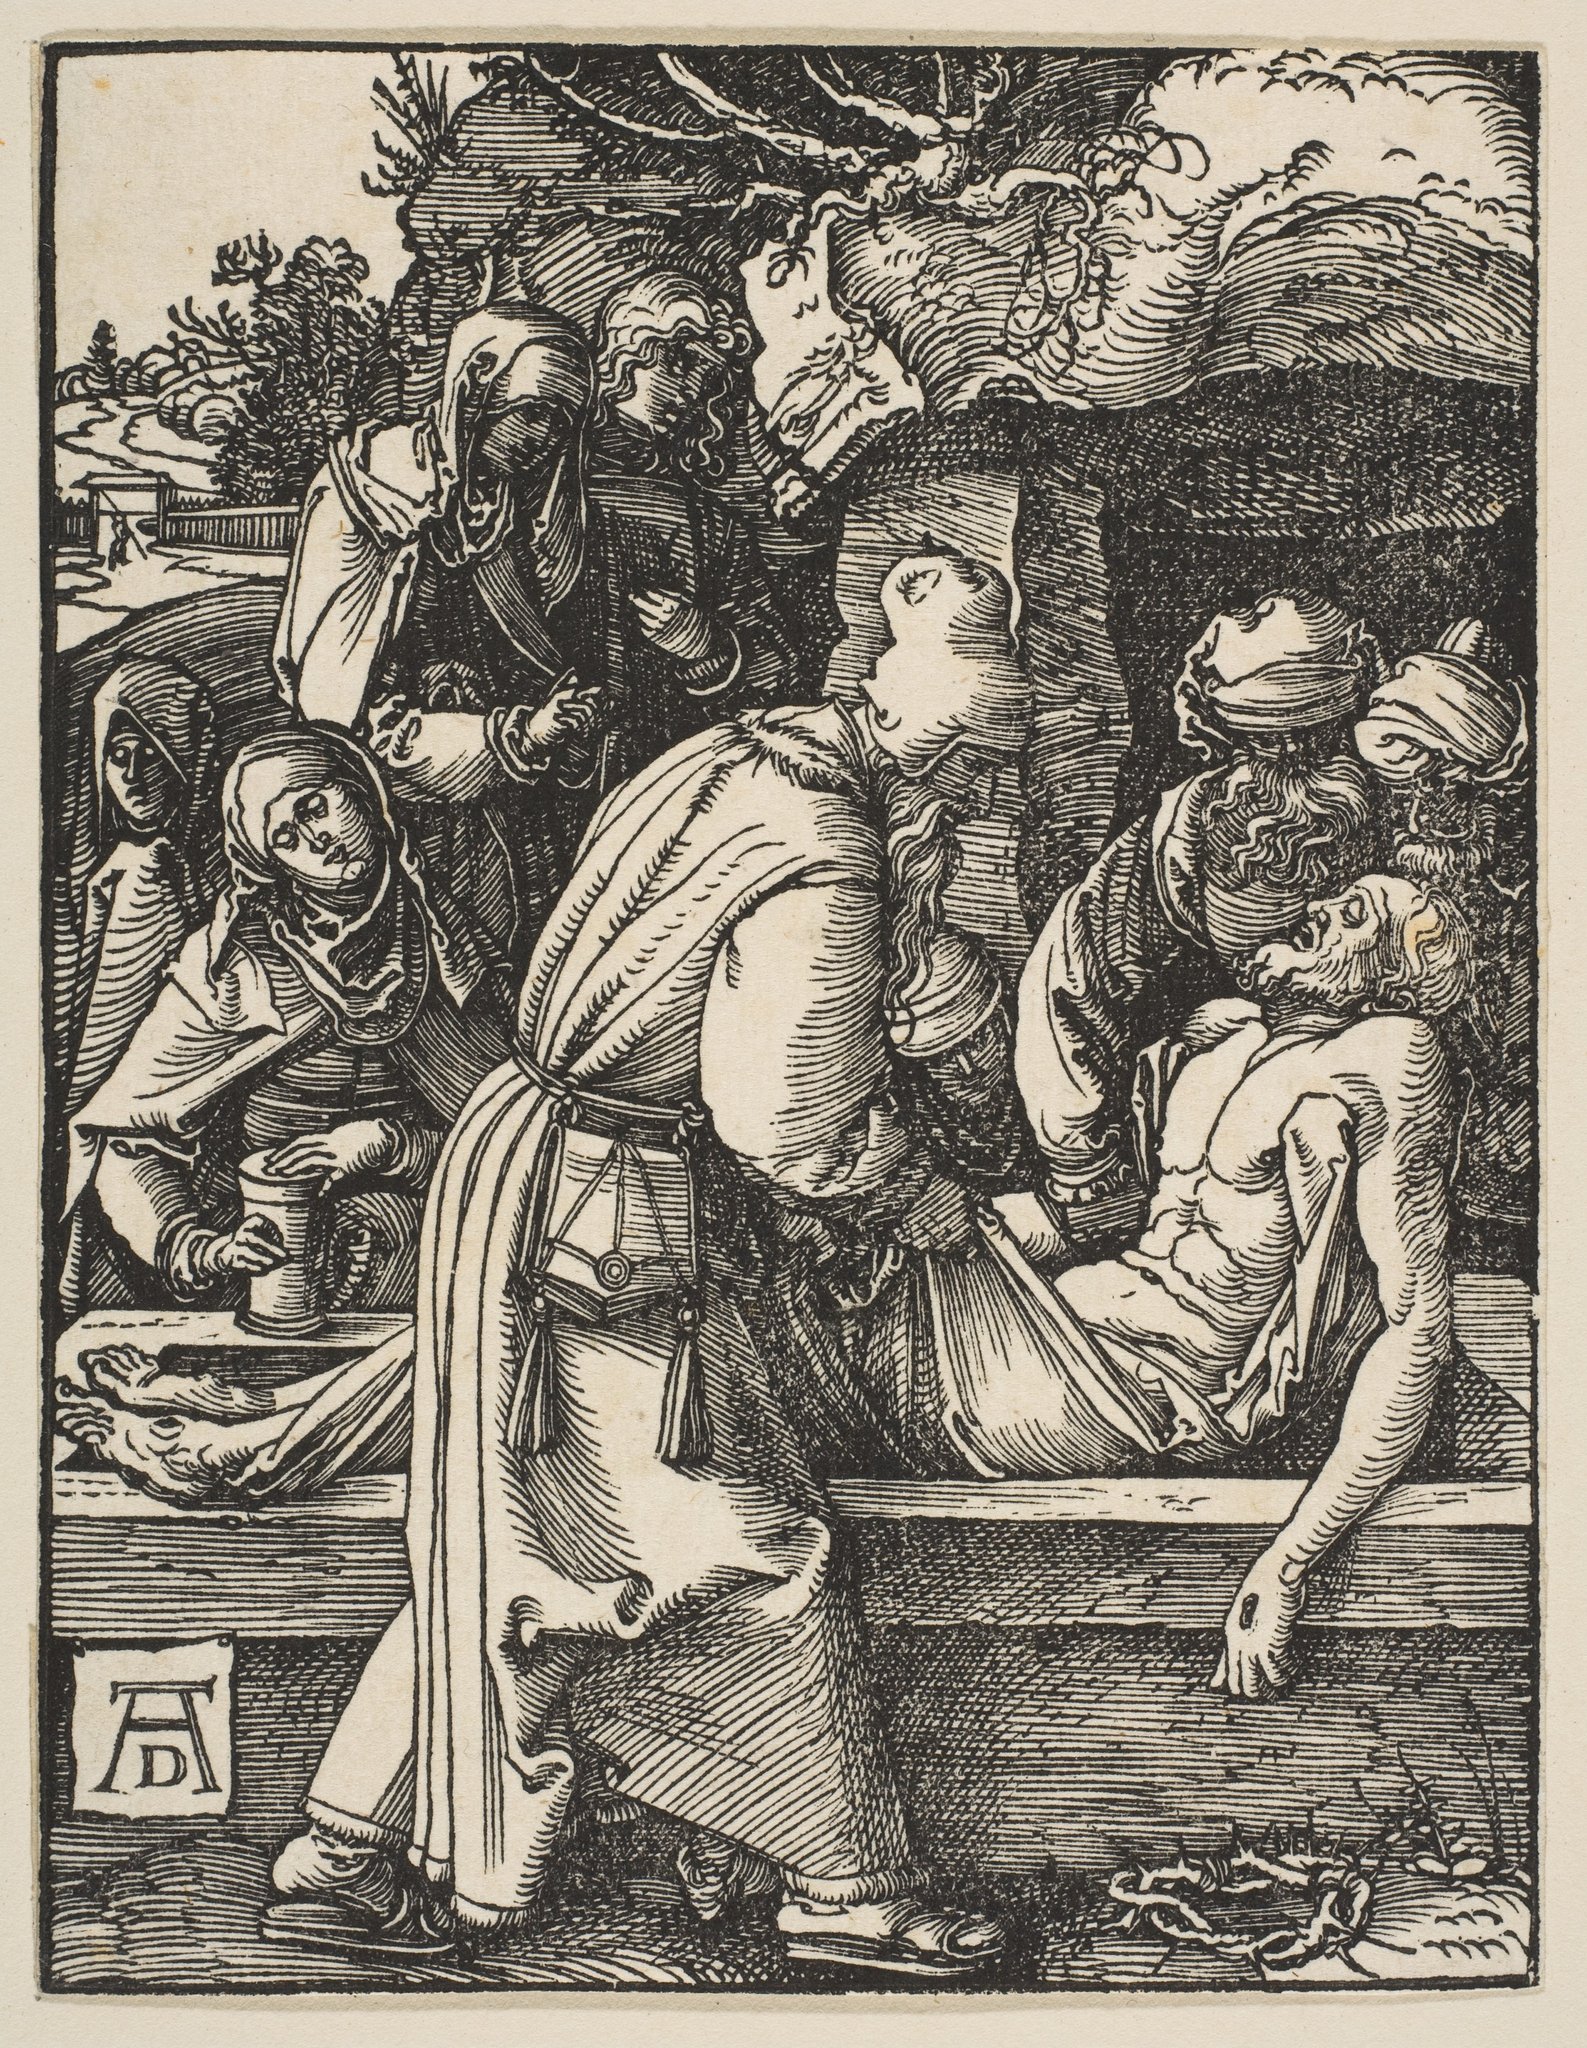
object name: print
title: The Deposition, from "The Small Passion"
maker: albrecht dürer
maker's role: artist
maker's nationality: german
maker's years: 1471-1528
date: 1509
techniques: woodcut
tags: men,women,christ,descent from the cross